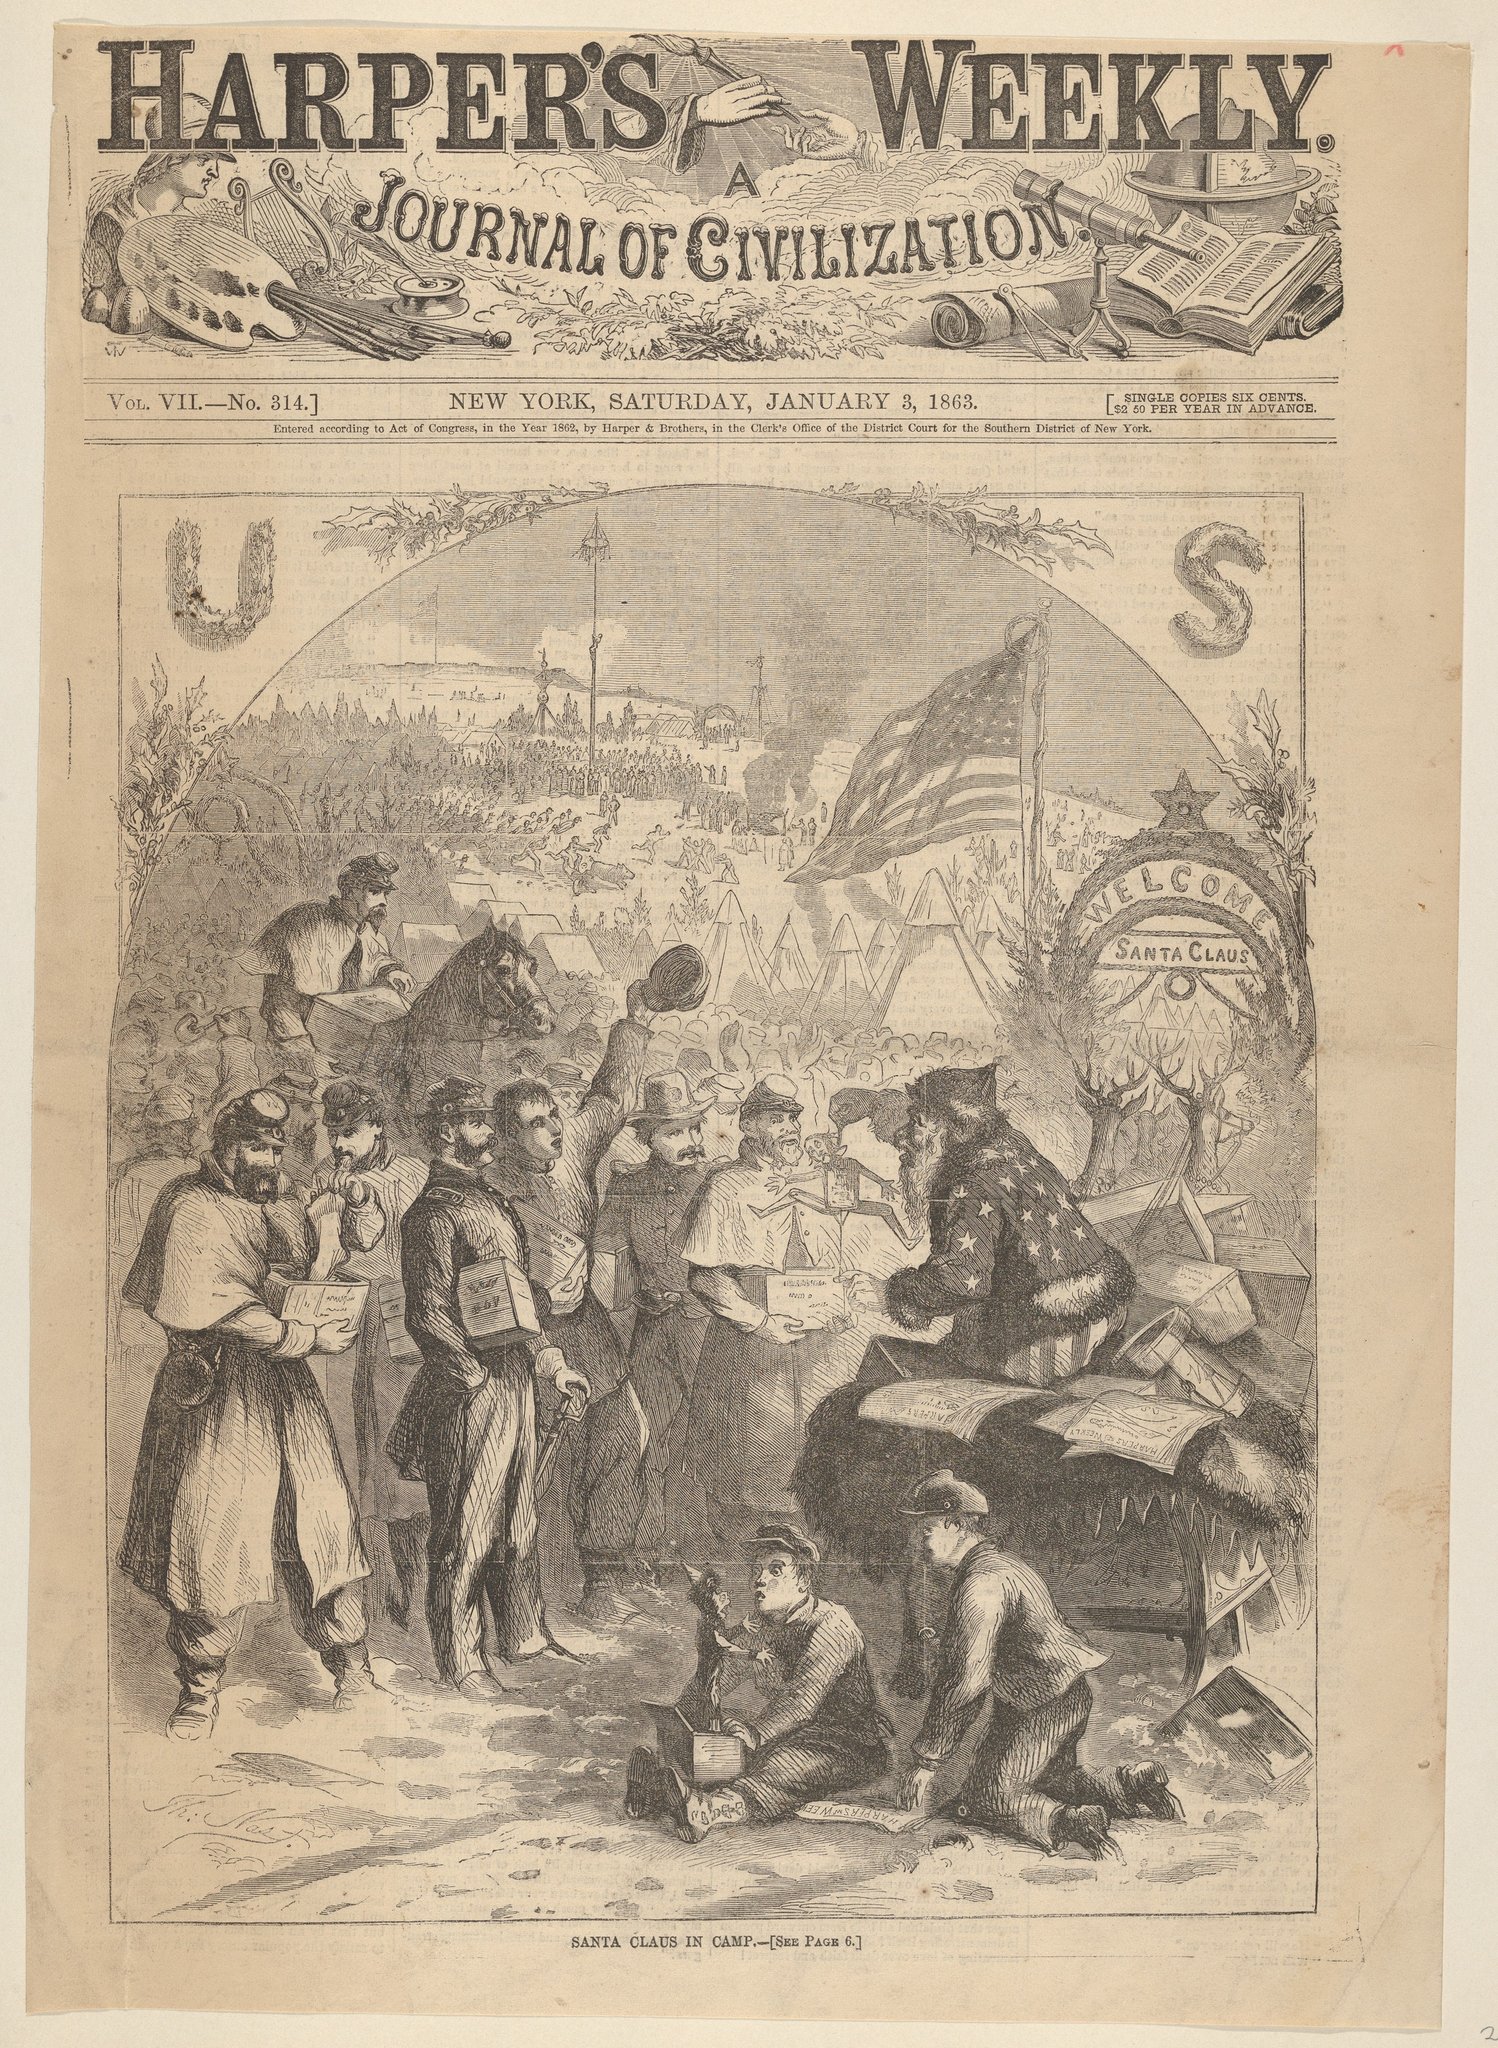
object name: print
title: Santa Claus in Camp (from "Harper's Weekly," vol. 7, p. 1)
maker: thomas nast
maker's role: artist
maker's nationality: american, born germany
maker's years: 1840-1902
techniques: engraving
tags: soldiers,american civil war,men,horses,christmas,santa claus